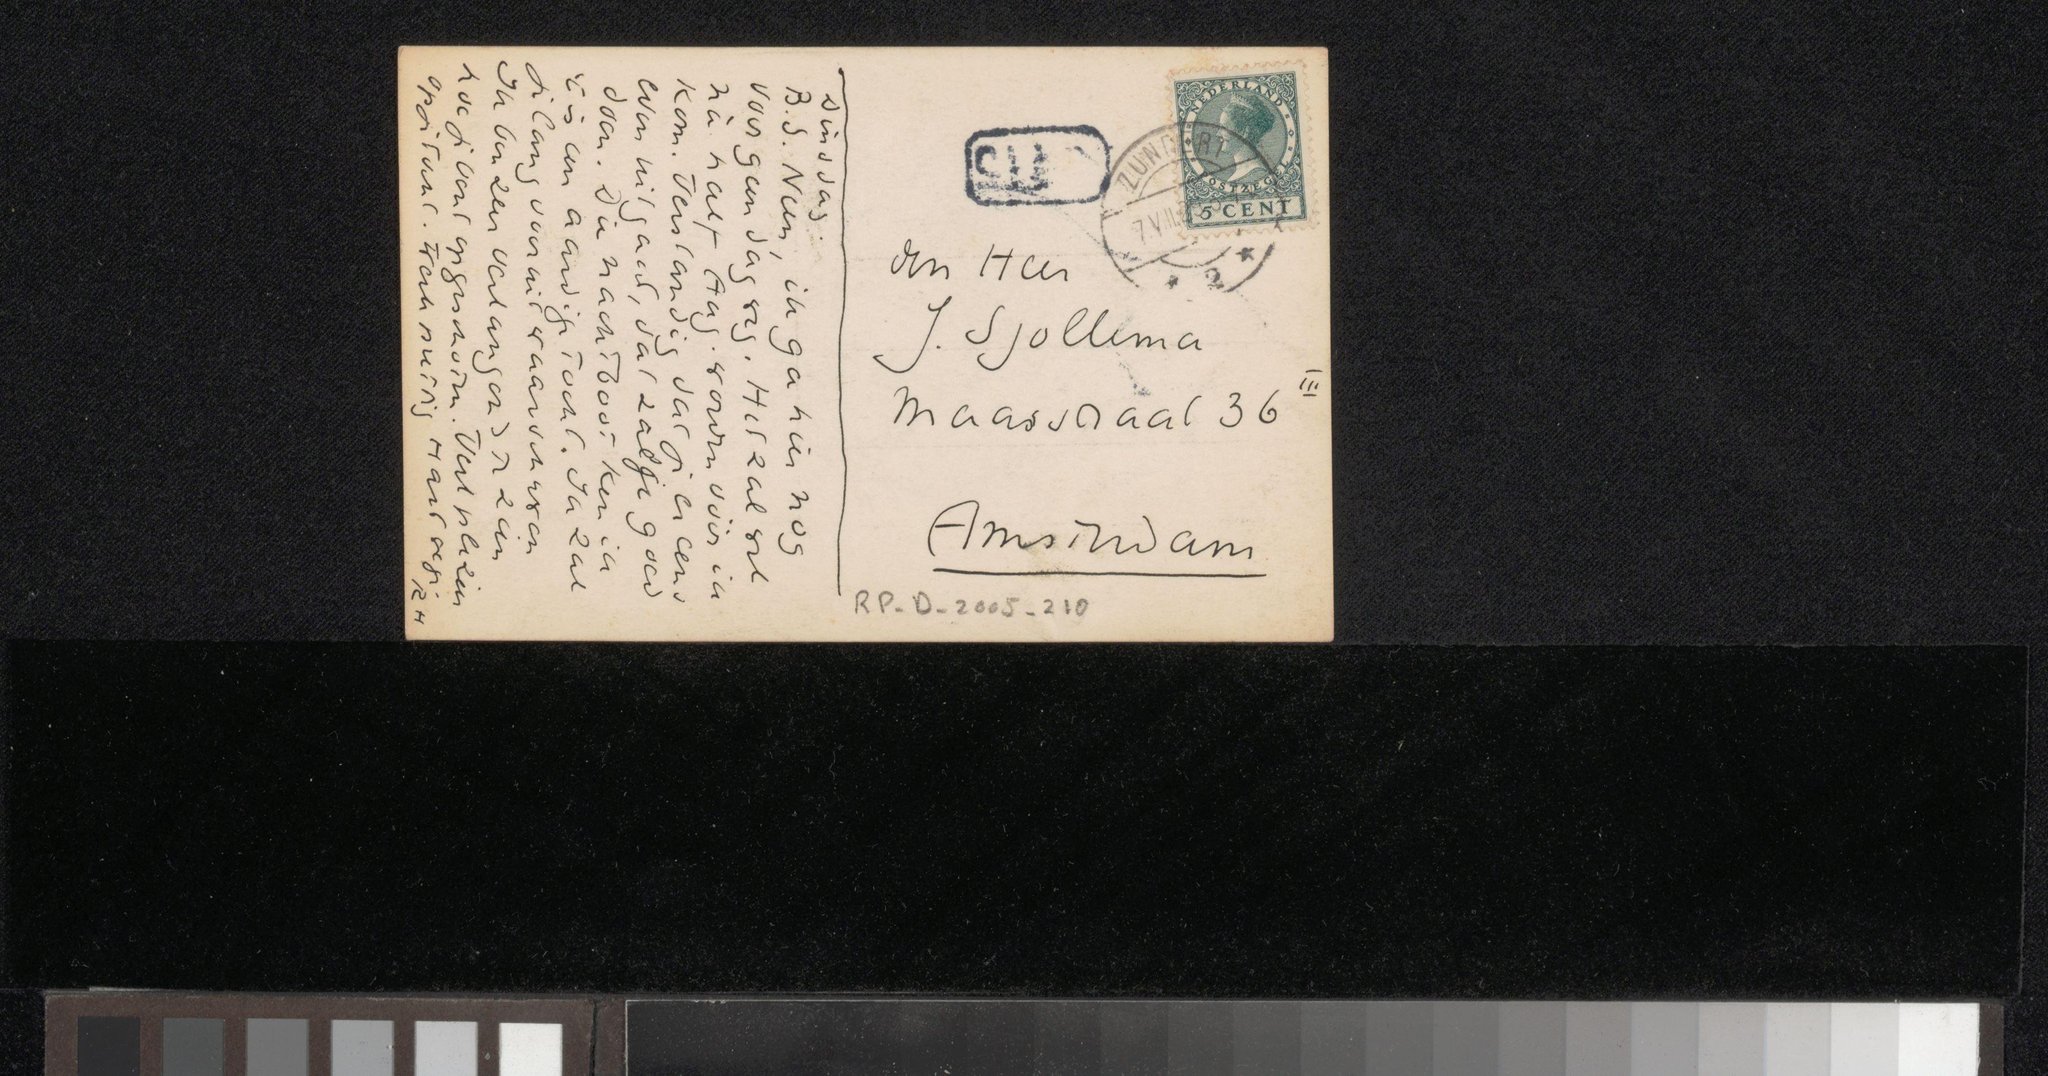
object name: ansichtkaart, prentbriefkaart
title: Prentbriefkaart aan Joop Sjollema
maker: richard nicolaüs roland holst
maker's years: 1868-1938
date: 1929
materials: cardboard, ink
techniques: gelatin silver print, pen, writing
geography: naples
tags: amsterdam, print maker, draughtsman, joop sjollema, travelling; tourism